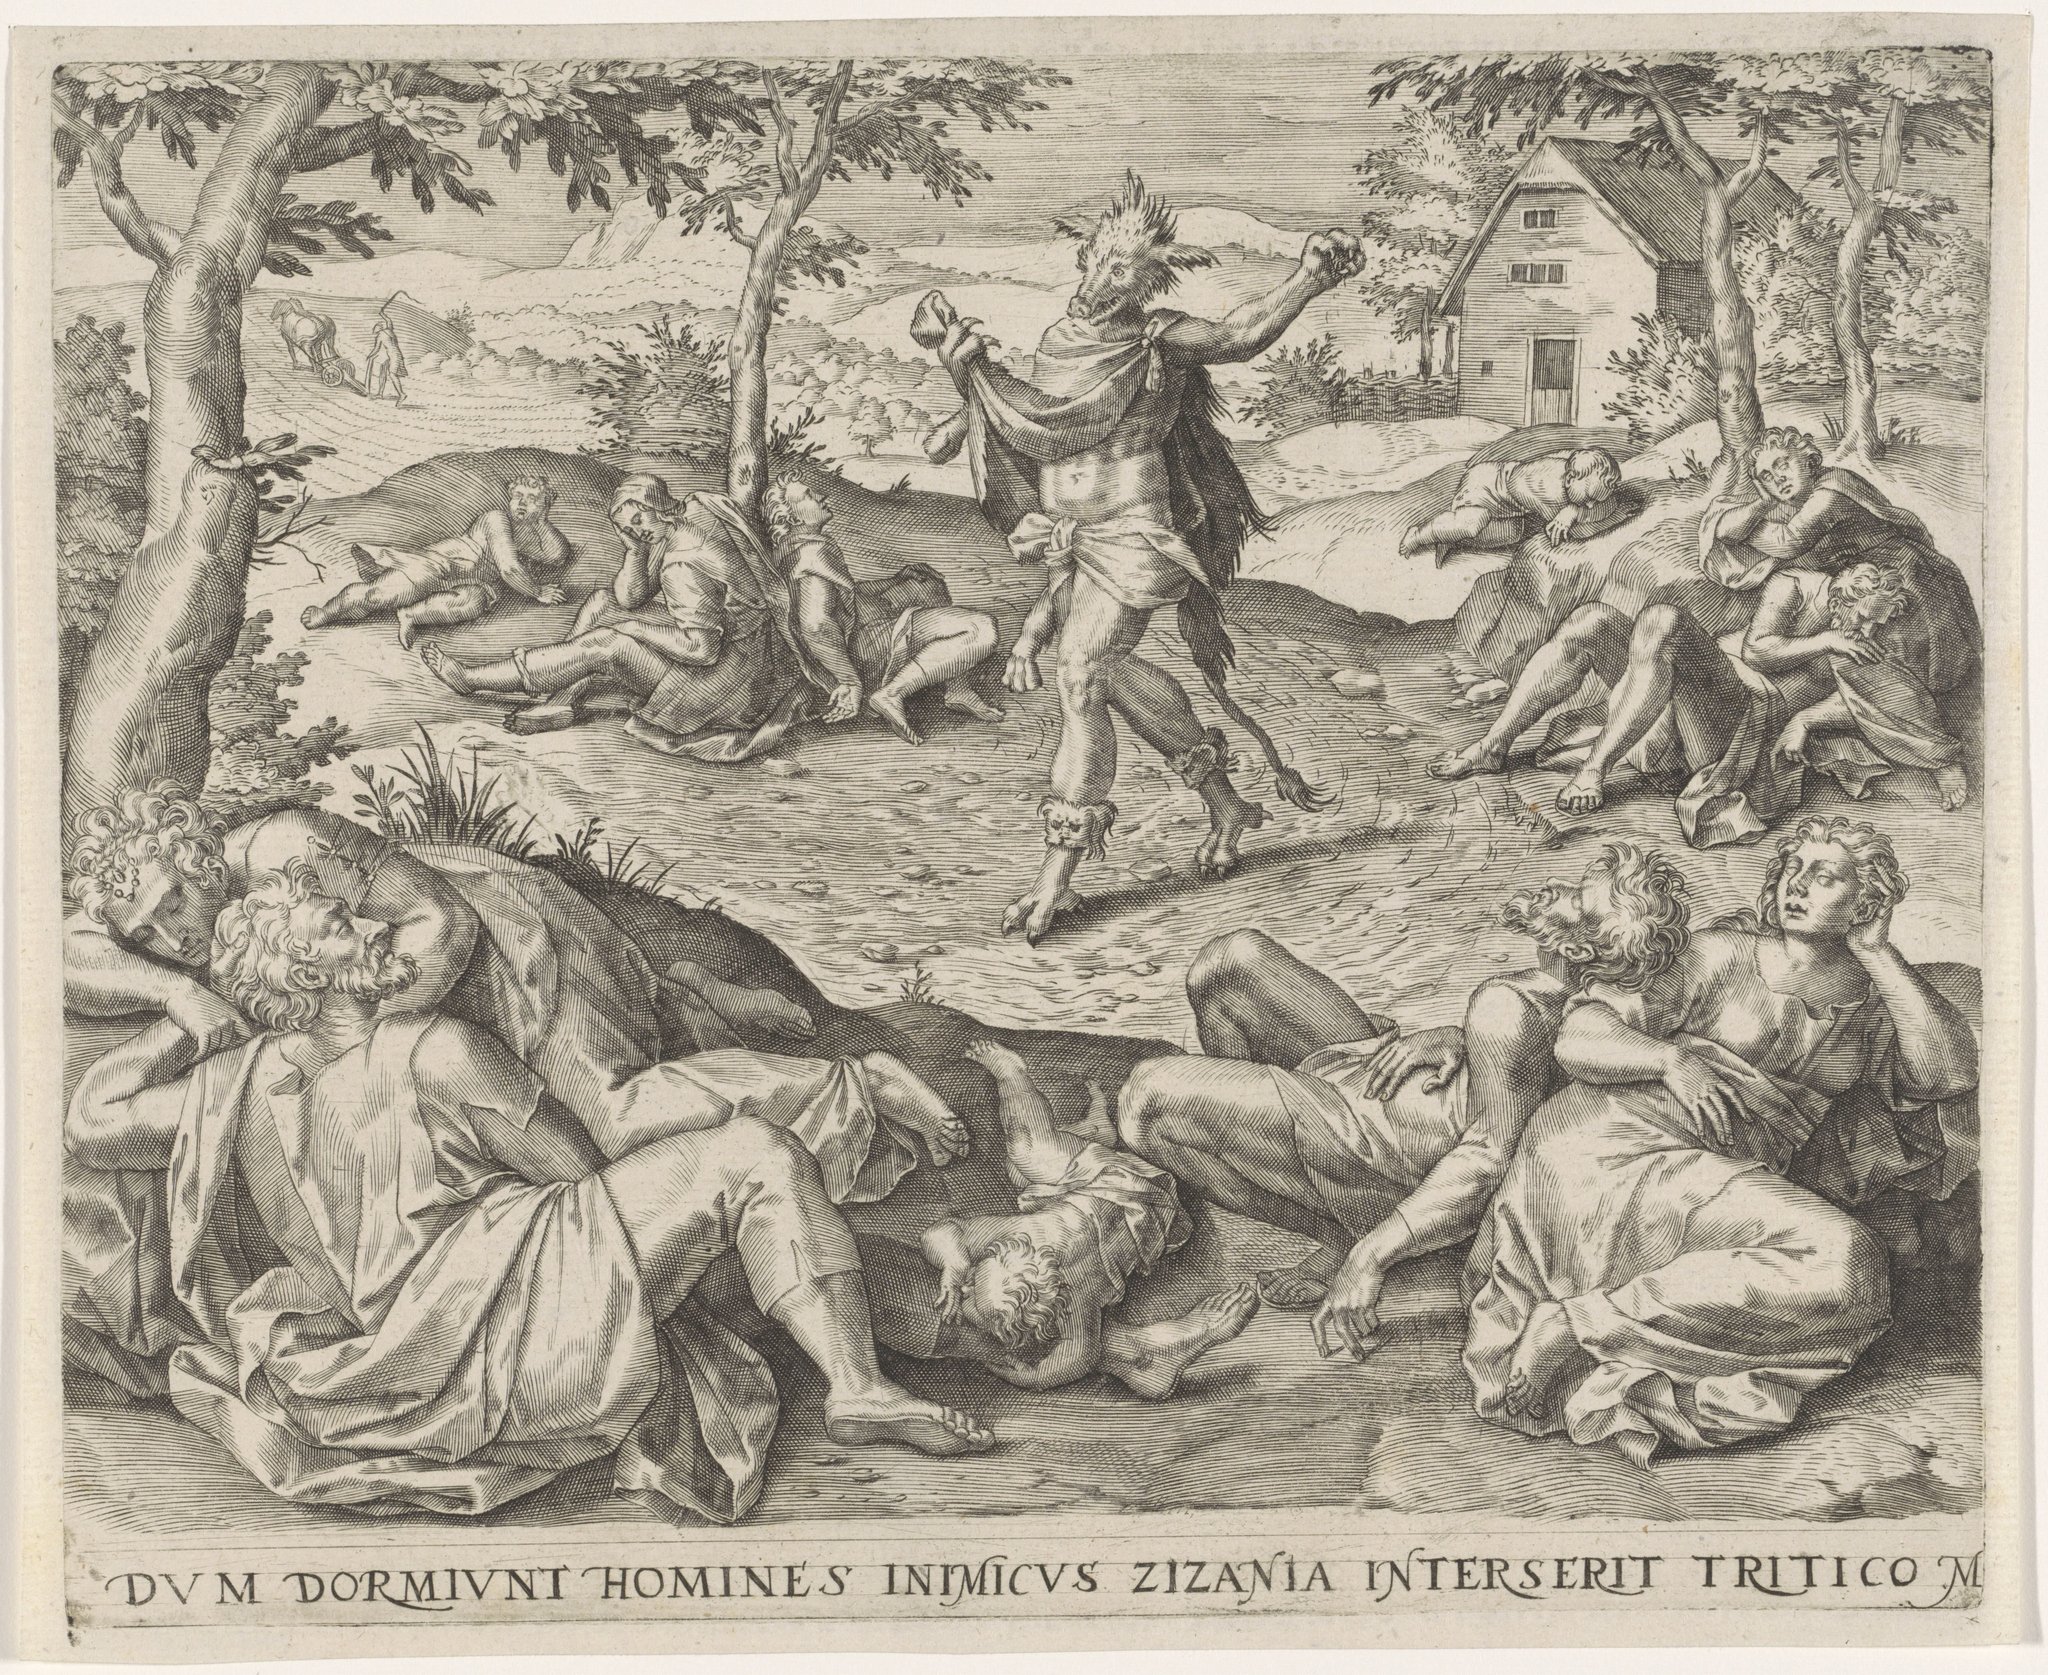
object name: print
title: Gelijkenis van de zaaier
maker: Anonymous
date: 1585-1700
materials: paper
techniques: engraving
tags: while the sower and his servants slept, his enemy (the devil) sowed tares among the wheat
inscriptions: collector's mark: Lugt 2233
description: Terwijl de landheer en zijn knechten slapen komt zijn vijand, de Duivel, om onkruid tussen het gezaaide graan te zaaien. De Duivel heeft een zwijnenkop als hoofd. Onder de voorstelling een verwijzing in het Latijn naar de Bijbeltekst in Mat. 13.